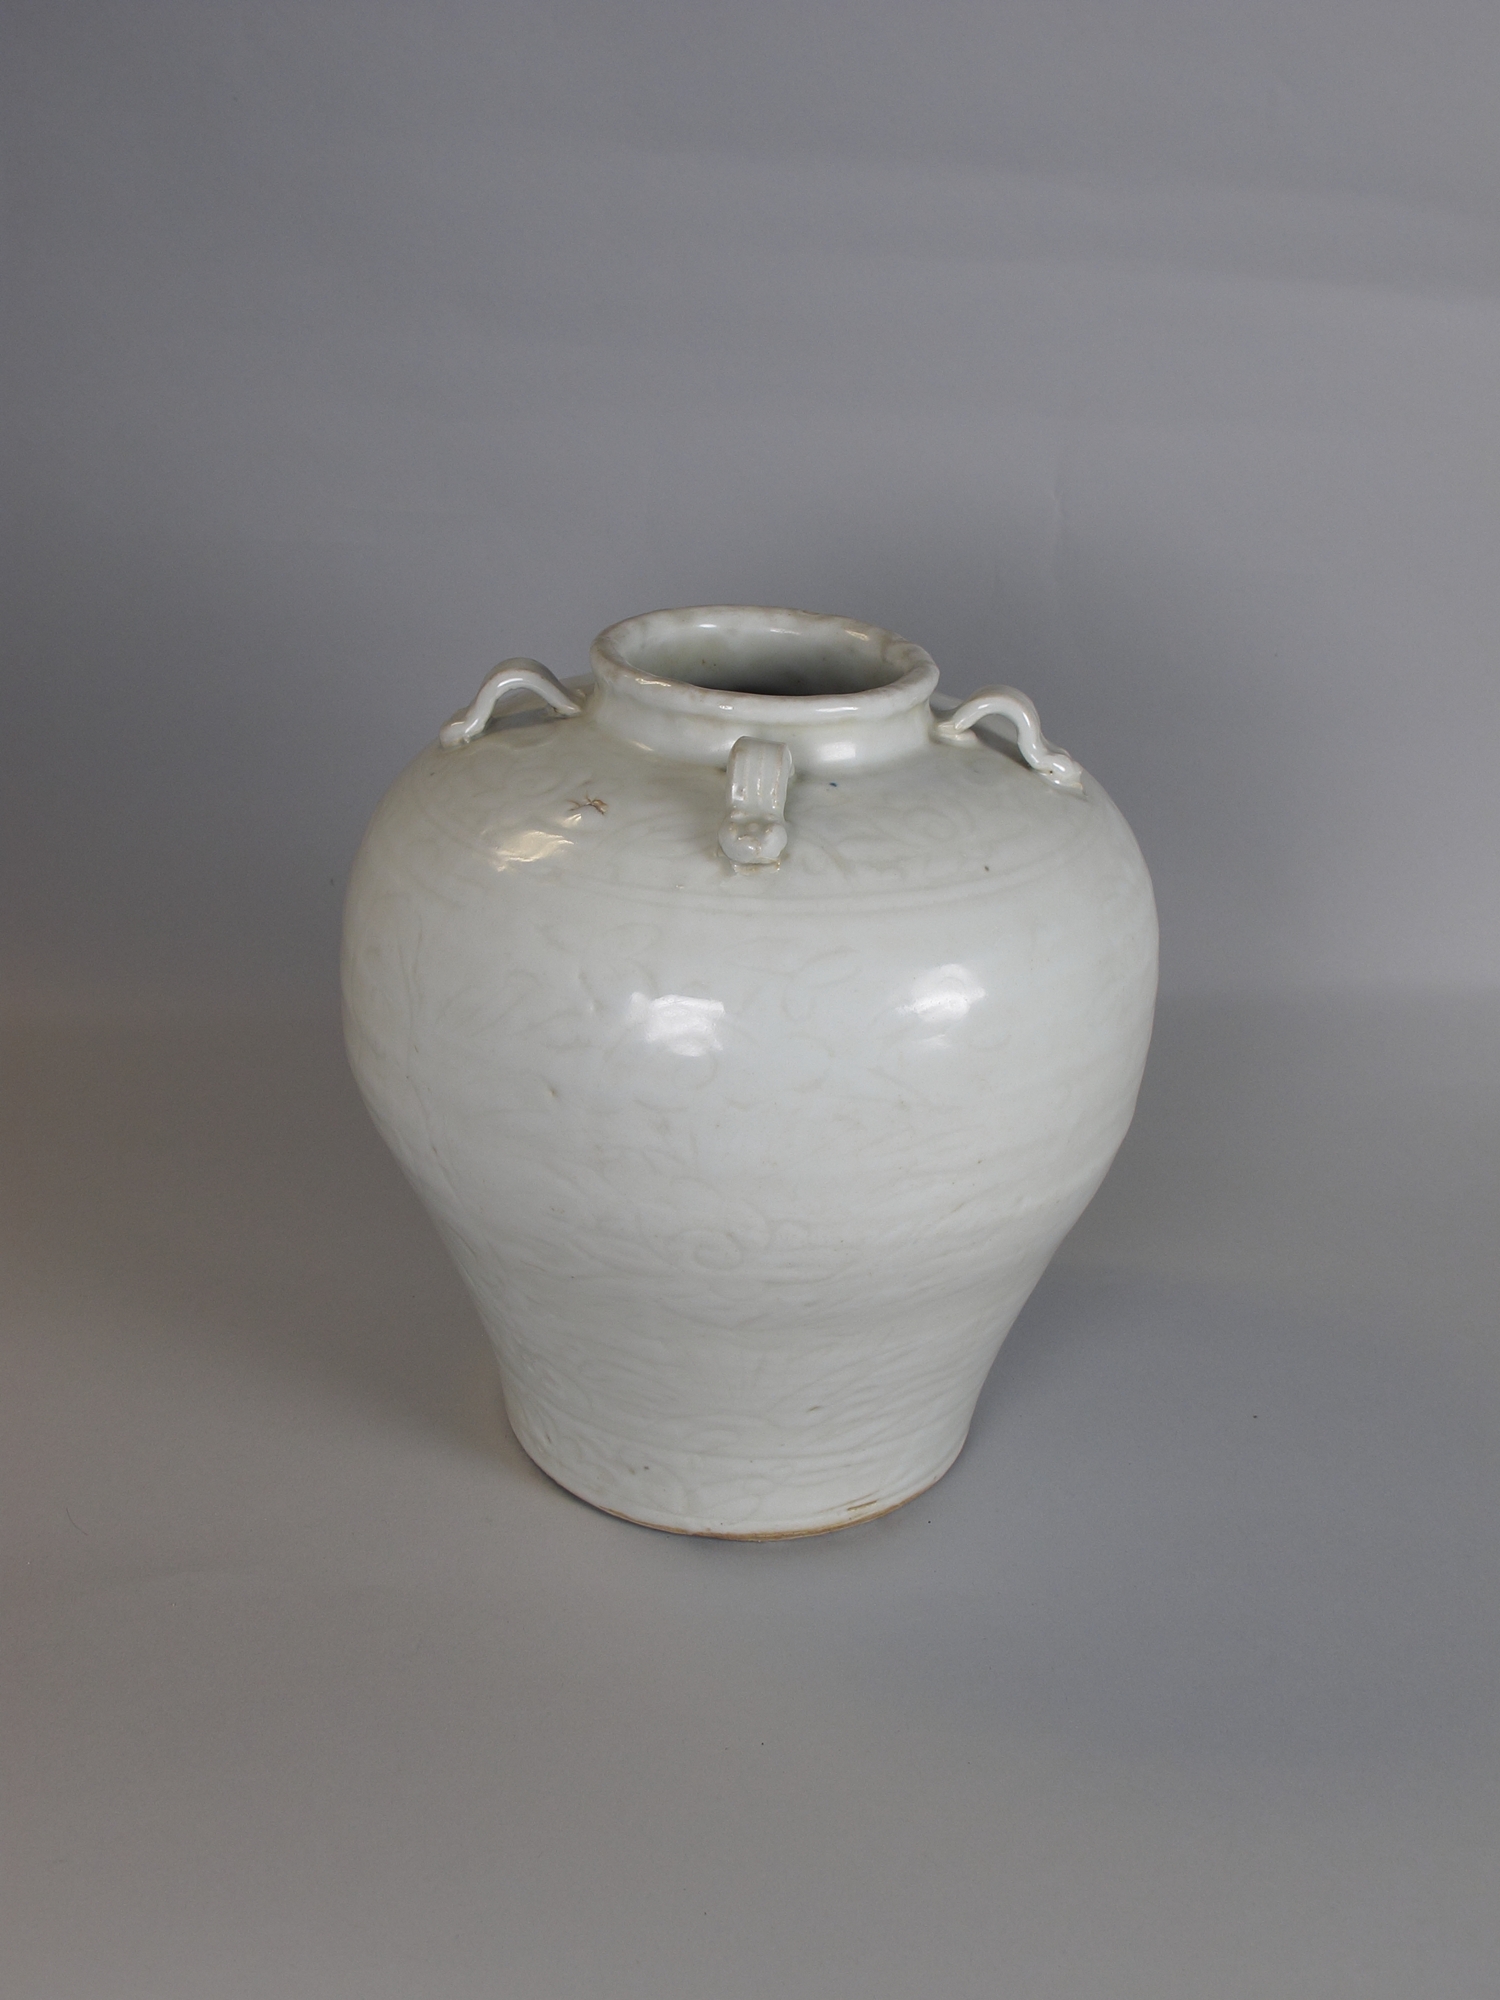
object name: jar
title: Jar with four lugs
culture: chinese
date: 1501-1600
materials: glaze, porcelain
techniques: incising